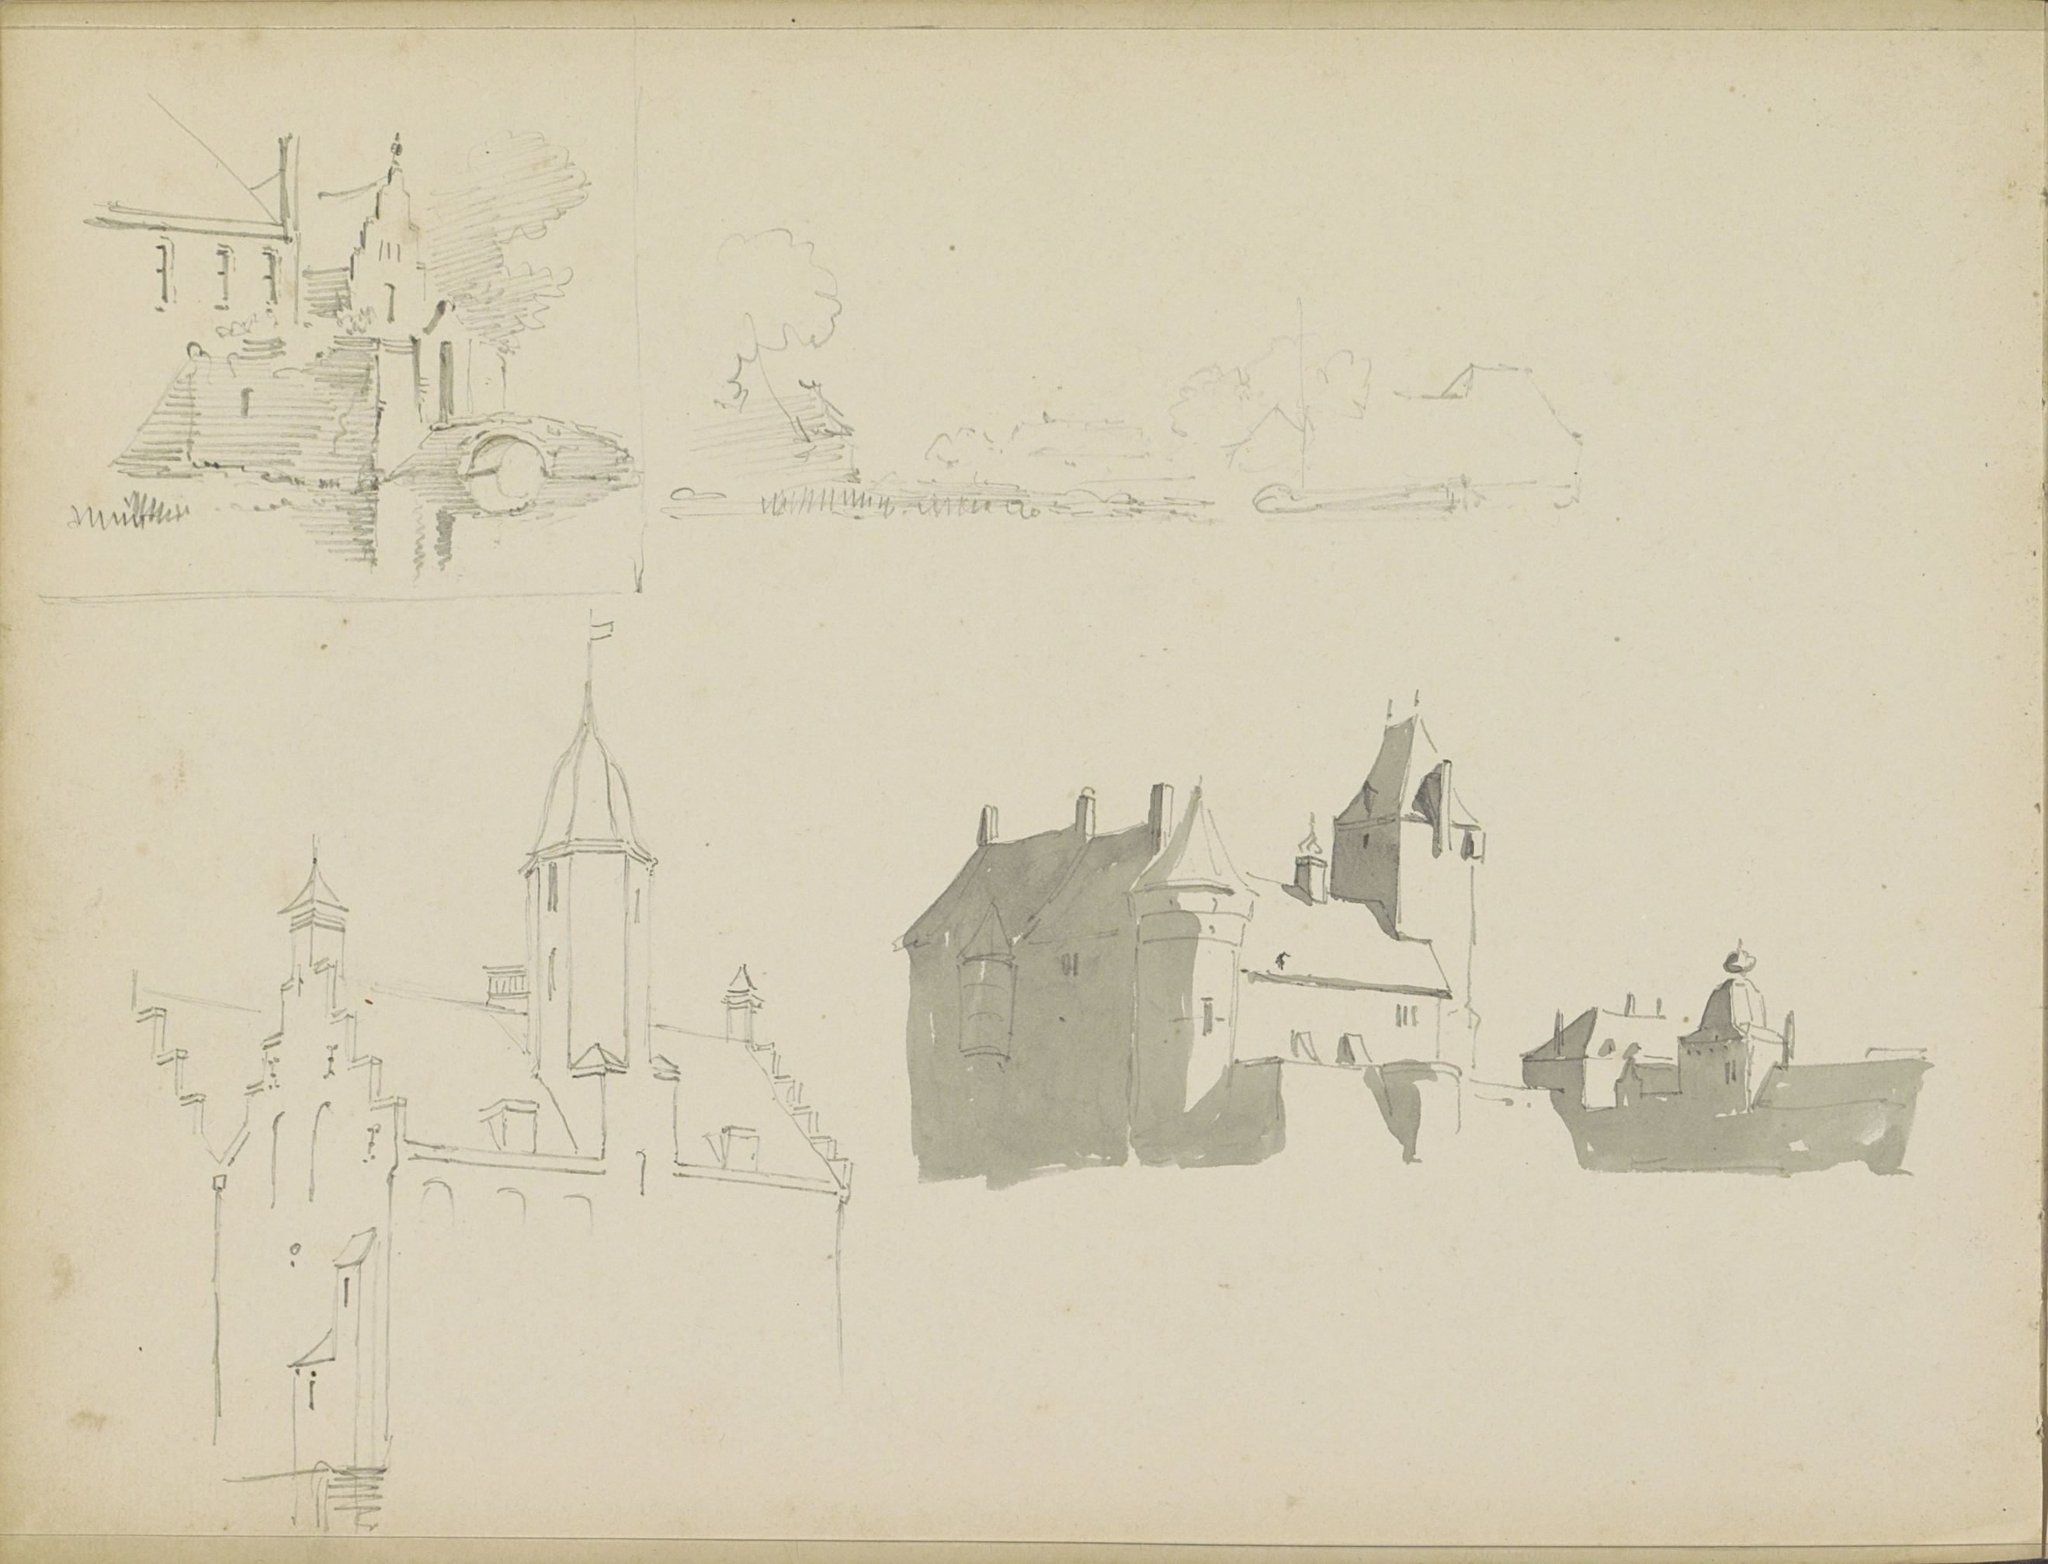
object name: sketchbook leaf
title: Studieblad met gebouwen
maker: adrianus eversen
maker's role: draughtsman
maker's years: 1818-1897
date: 1828-1897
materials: paper, pencil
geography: netherlands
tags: castle, civic architecture; edifices; dwellings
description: Studieblad met gebouwen, mogelijk kastelen of buitenplaatsen. Blad 26 verso uit een schetsboek met 41 bladen.